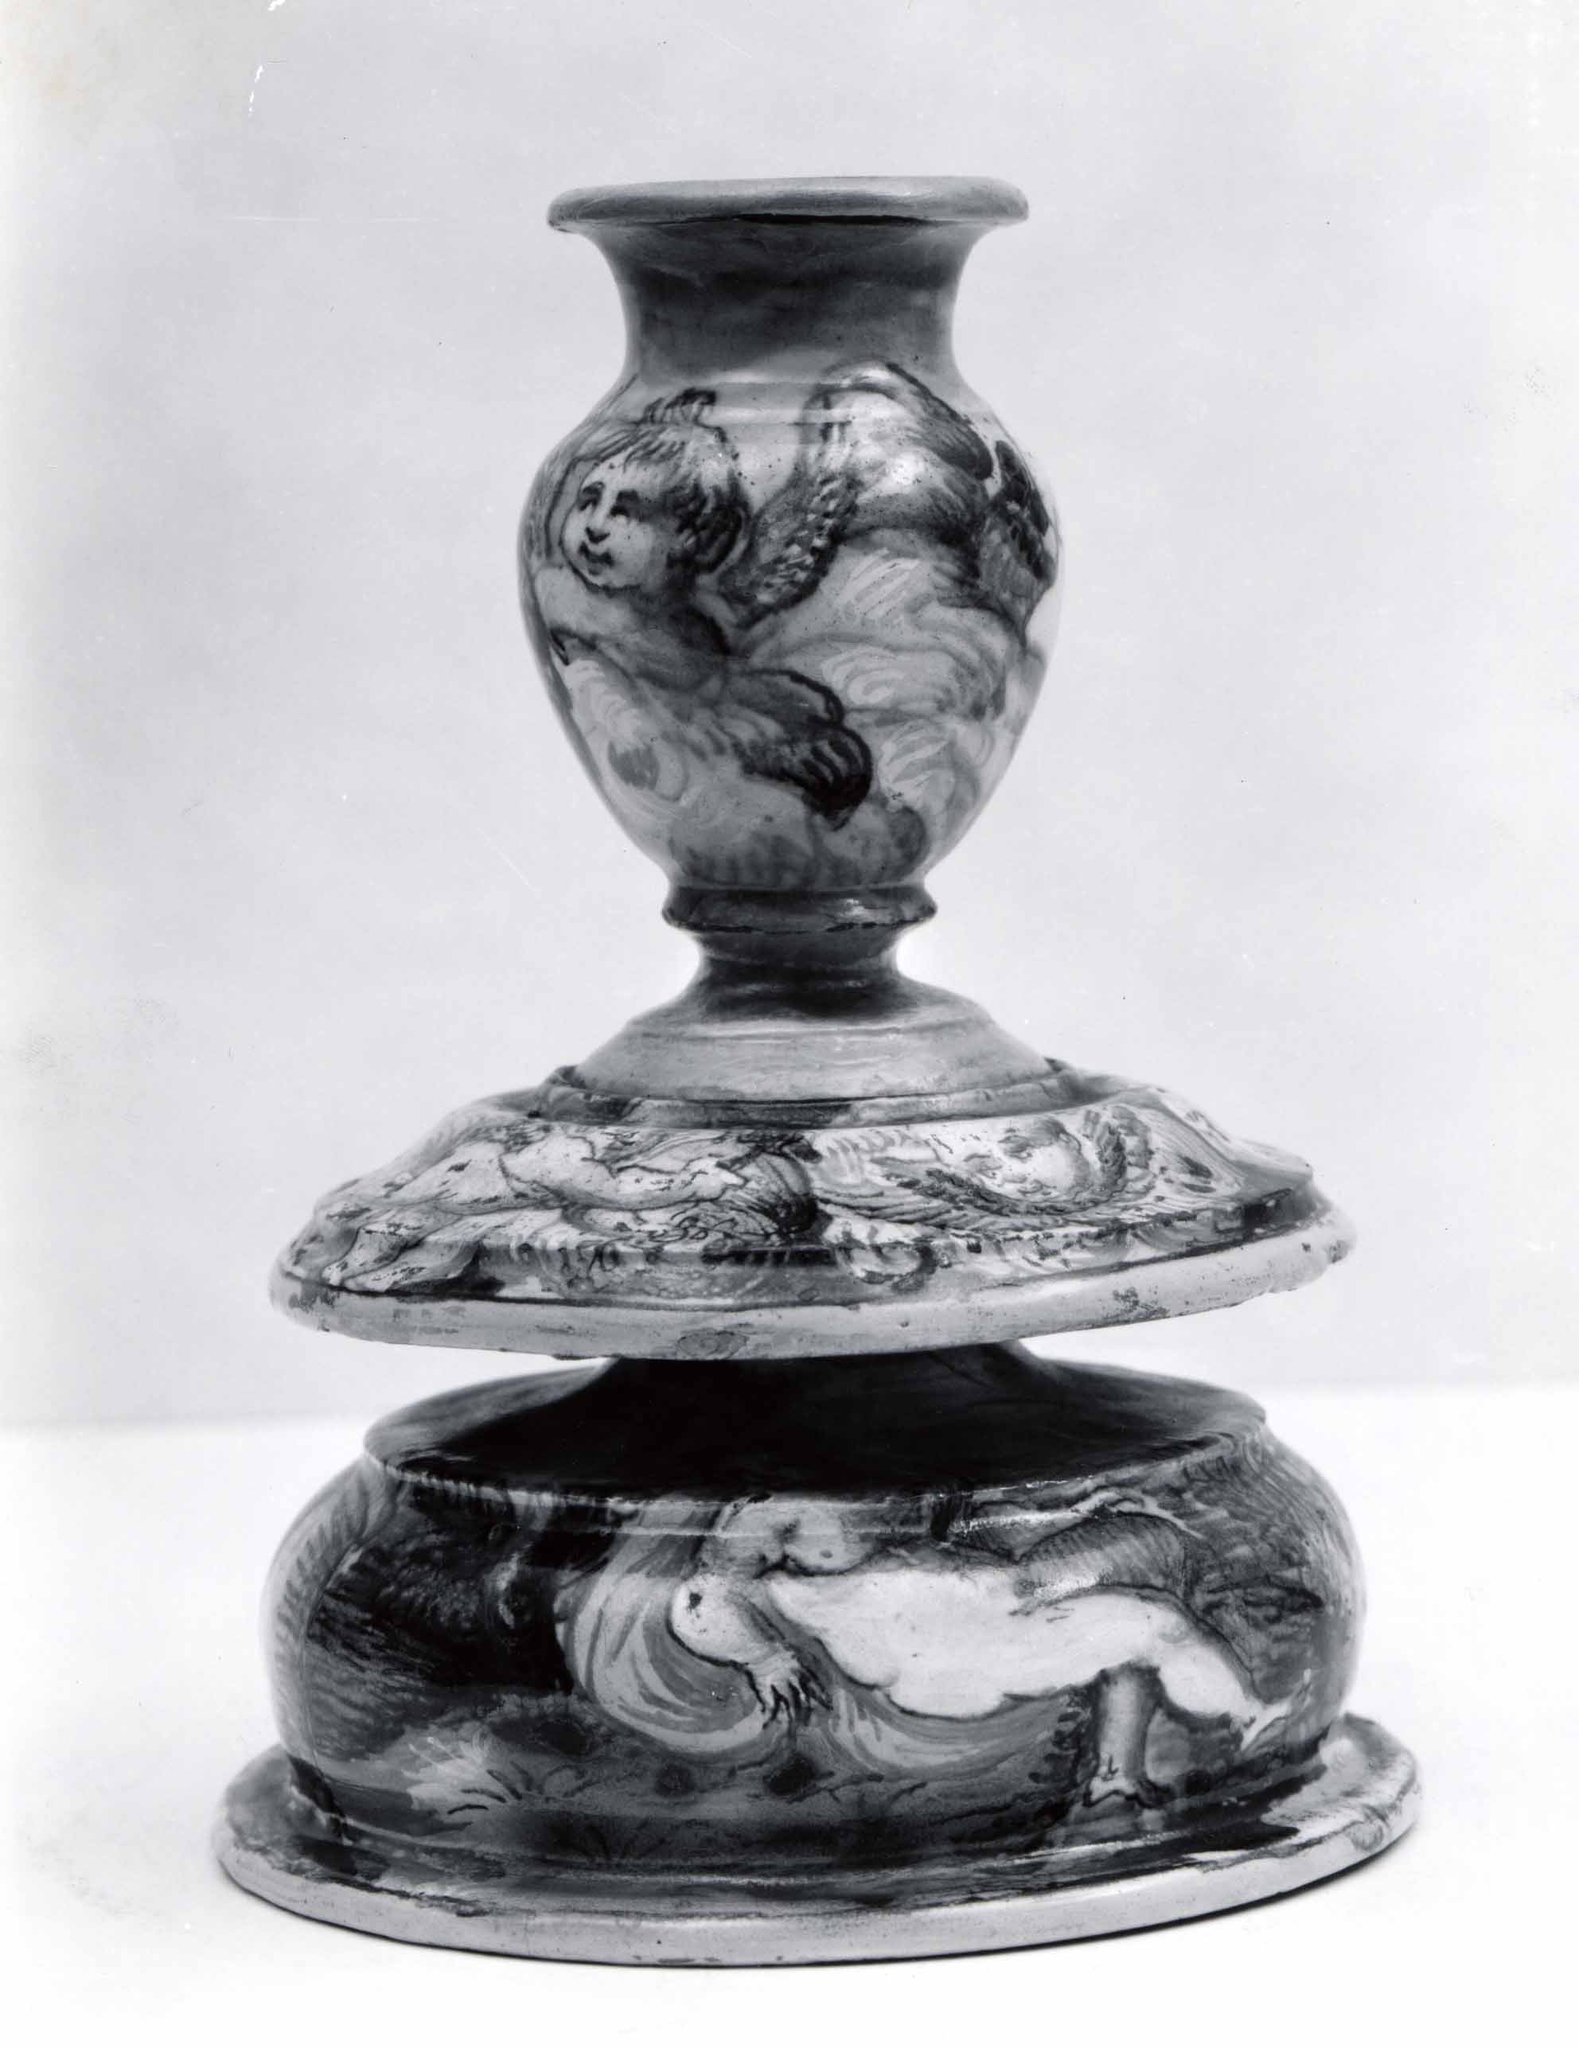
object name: candlestick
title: Candlestick (candeliere)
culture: italian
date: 1560-1580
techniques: maiolica, glazing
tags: putti